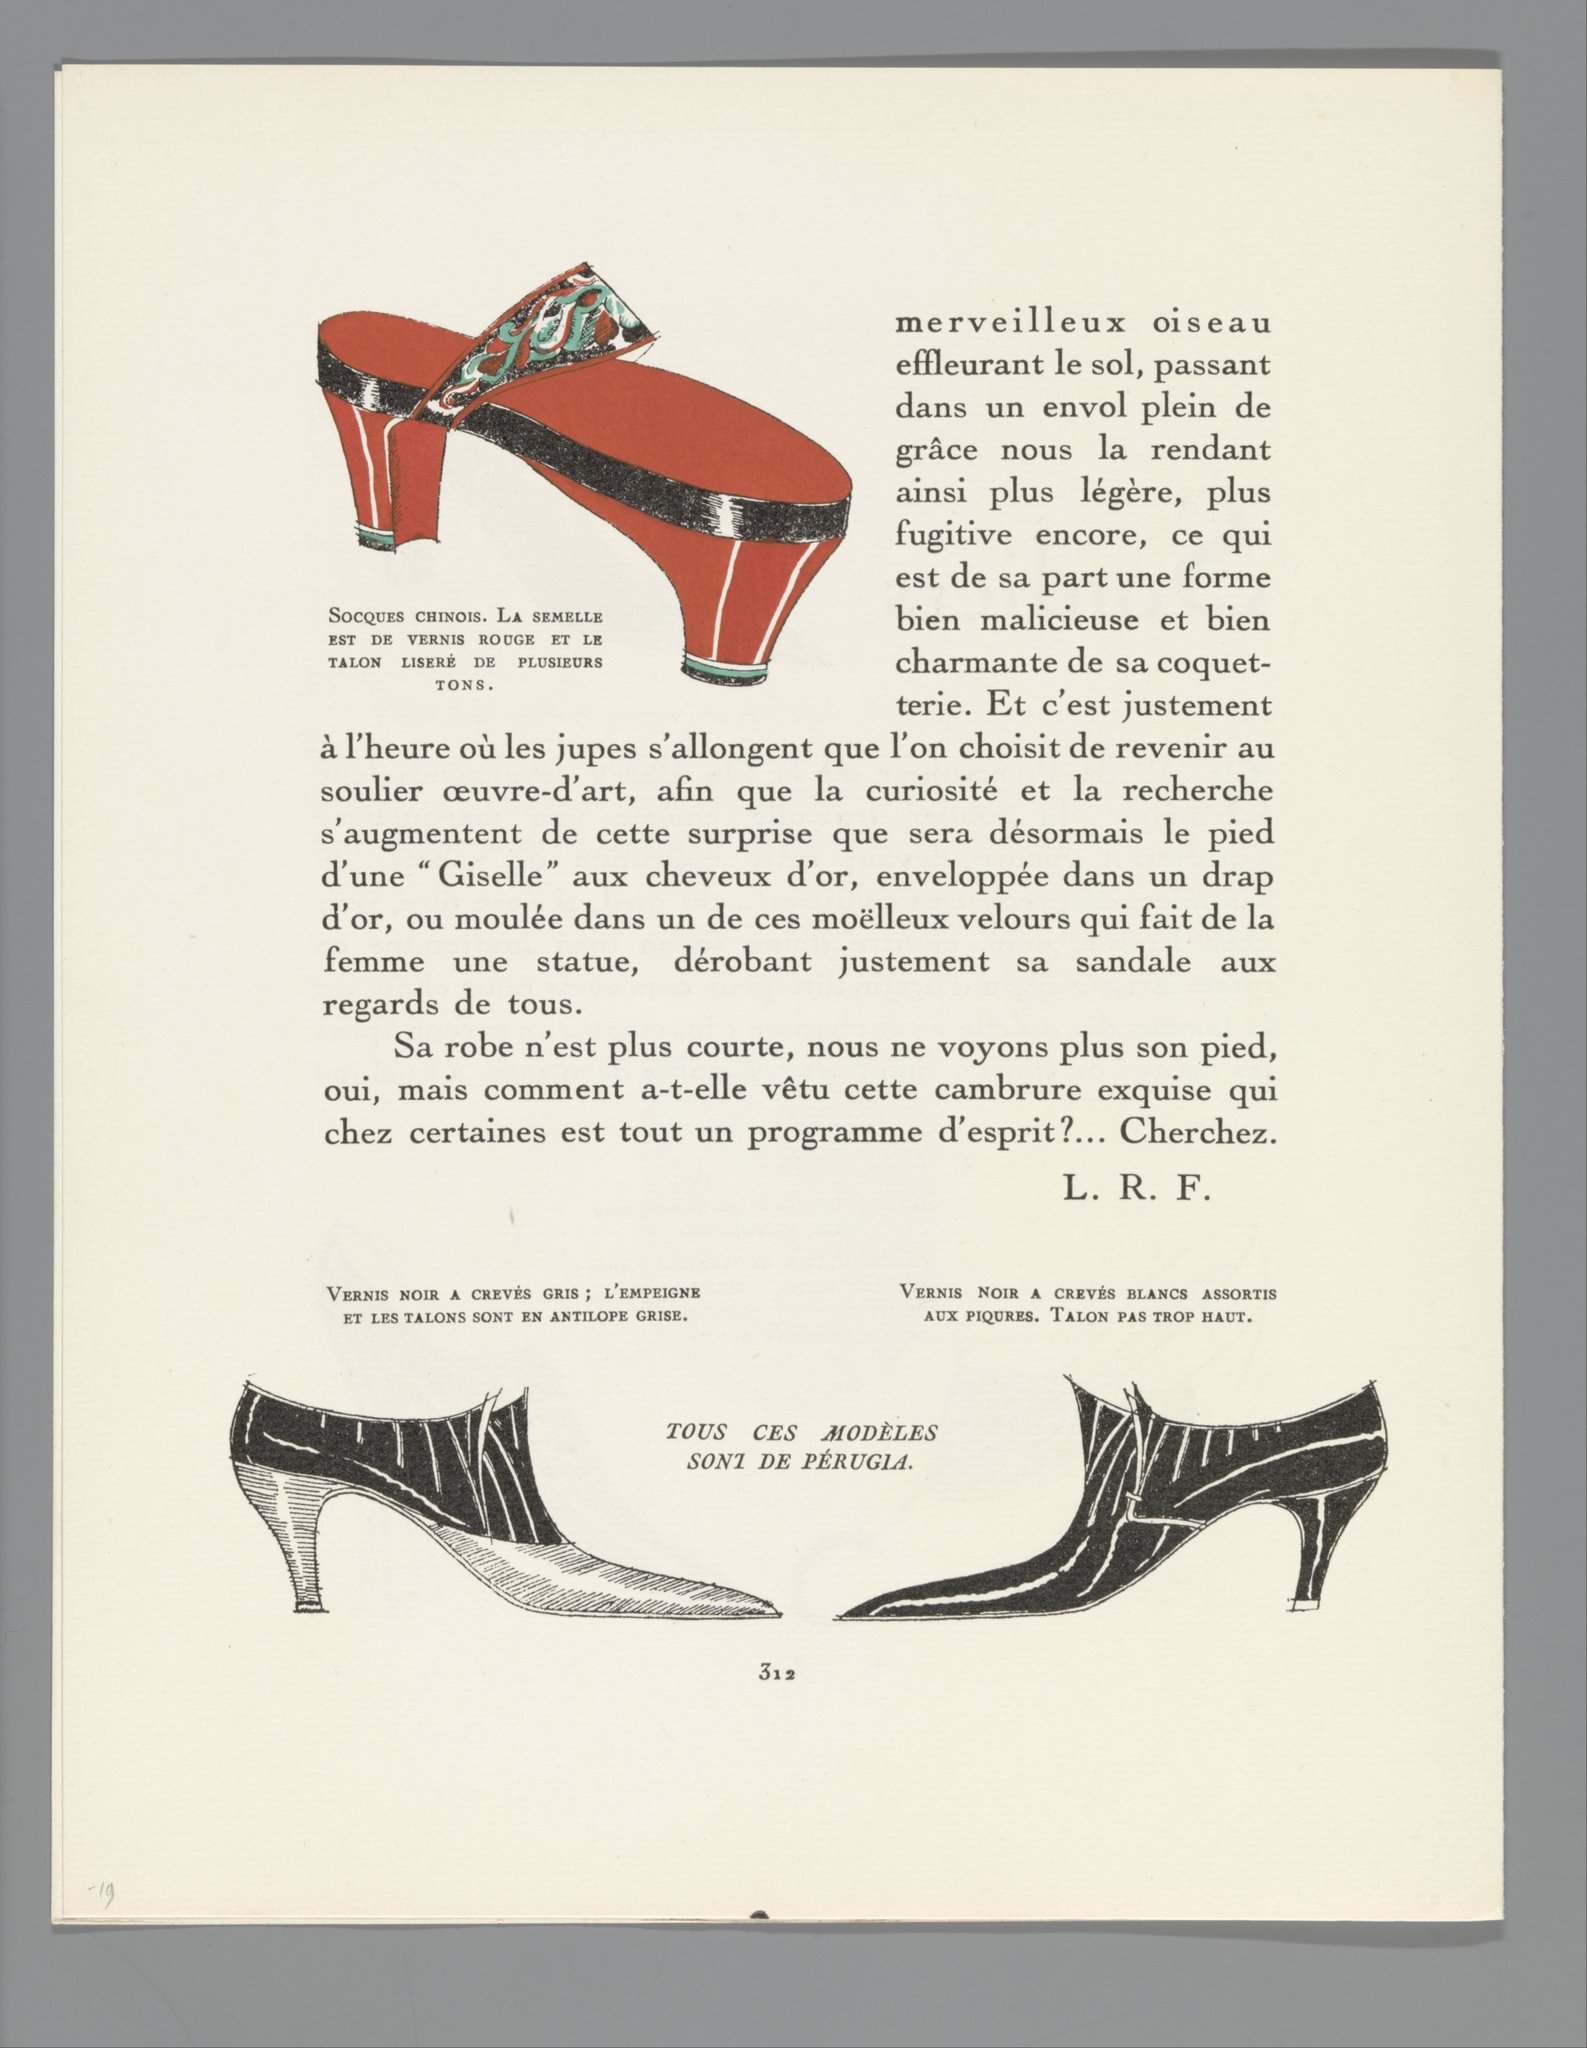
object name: fashion print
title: Gazette du Bon Ton, 1921 - No. 10, p. 311: "Souliers" : damesschoenen van Pérugia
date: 1921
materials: paper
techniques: hand coloring, letterpress printing, lithograph, photochemical processes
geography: buenos aires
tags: fashion plates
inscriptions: date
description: Pag. 312: "Souliers". Tekst over damesschoenen van Pérugia. Twee illustraties van pumps, een van een Chinese muil.